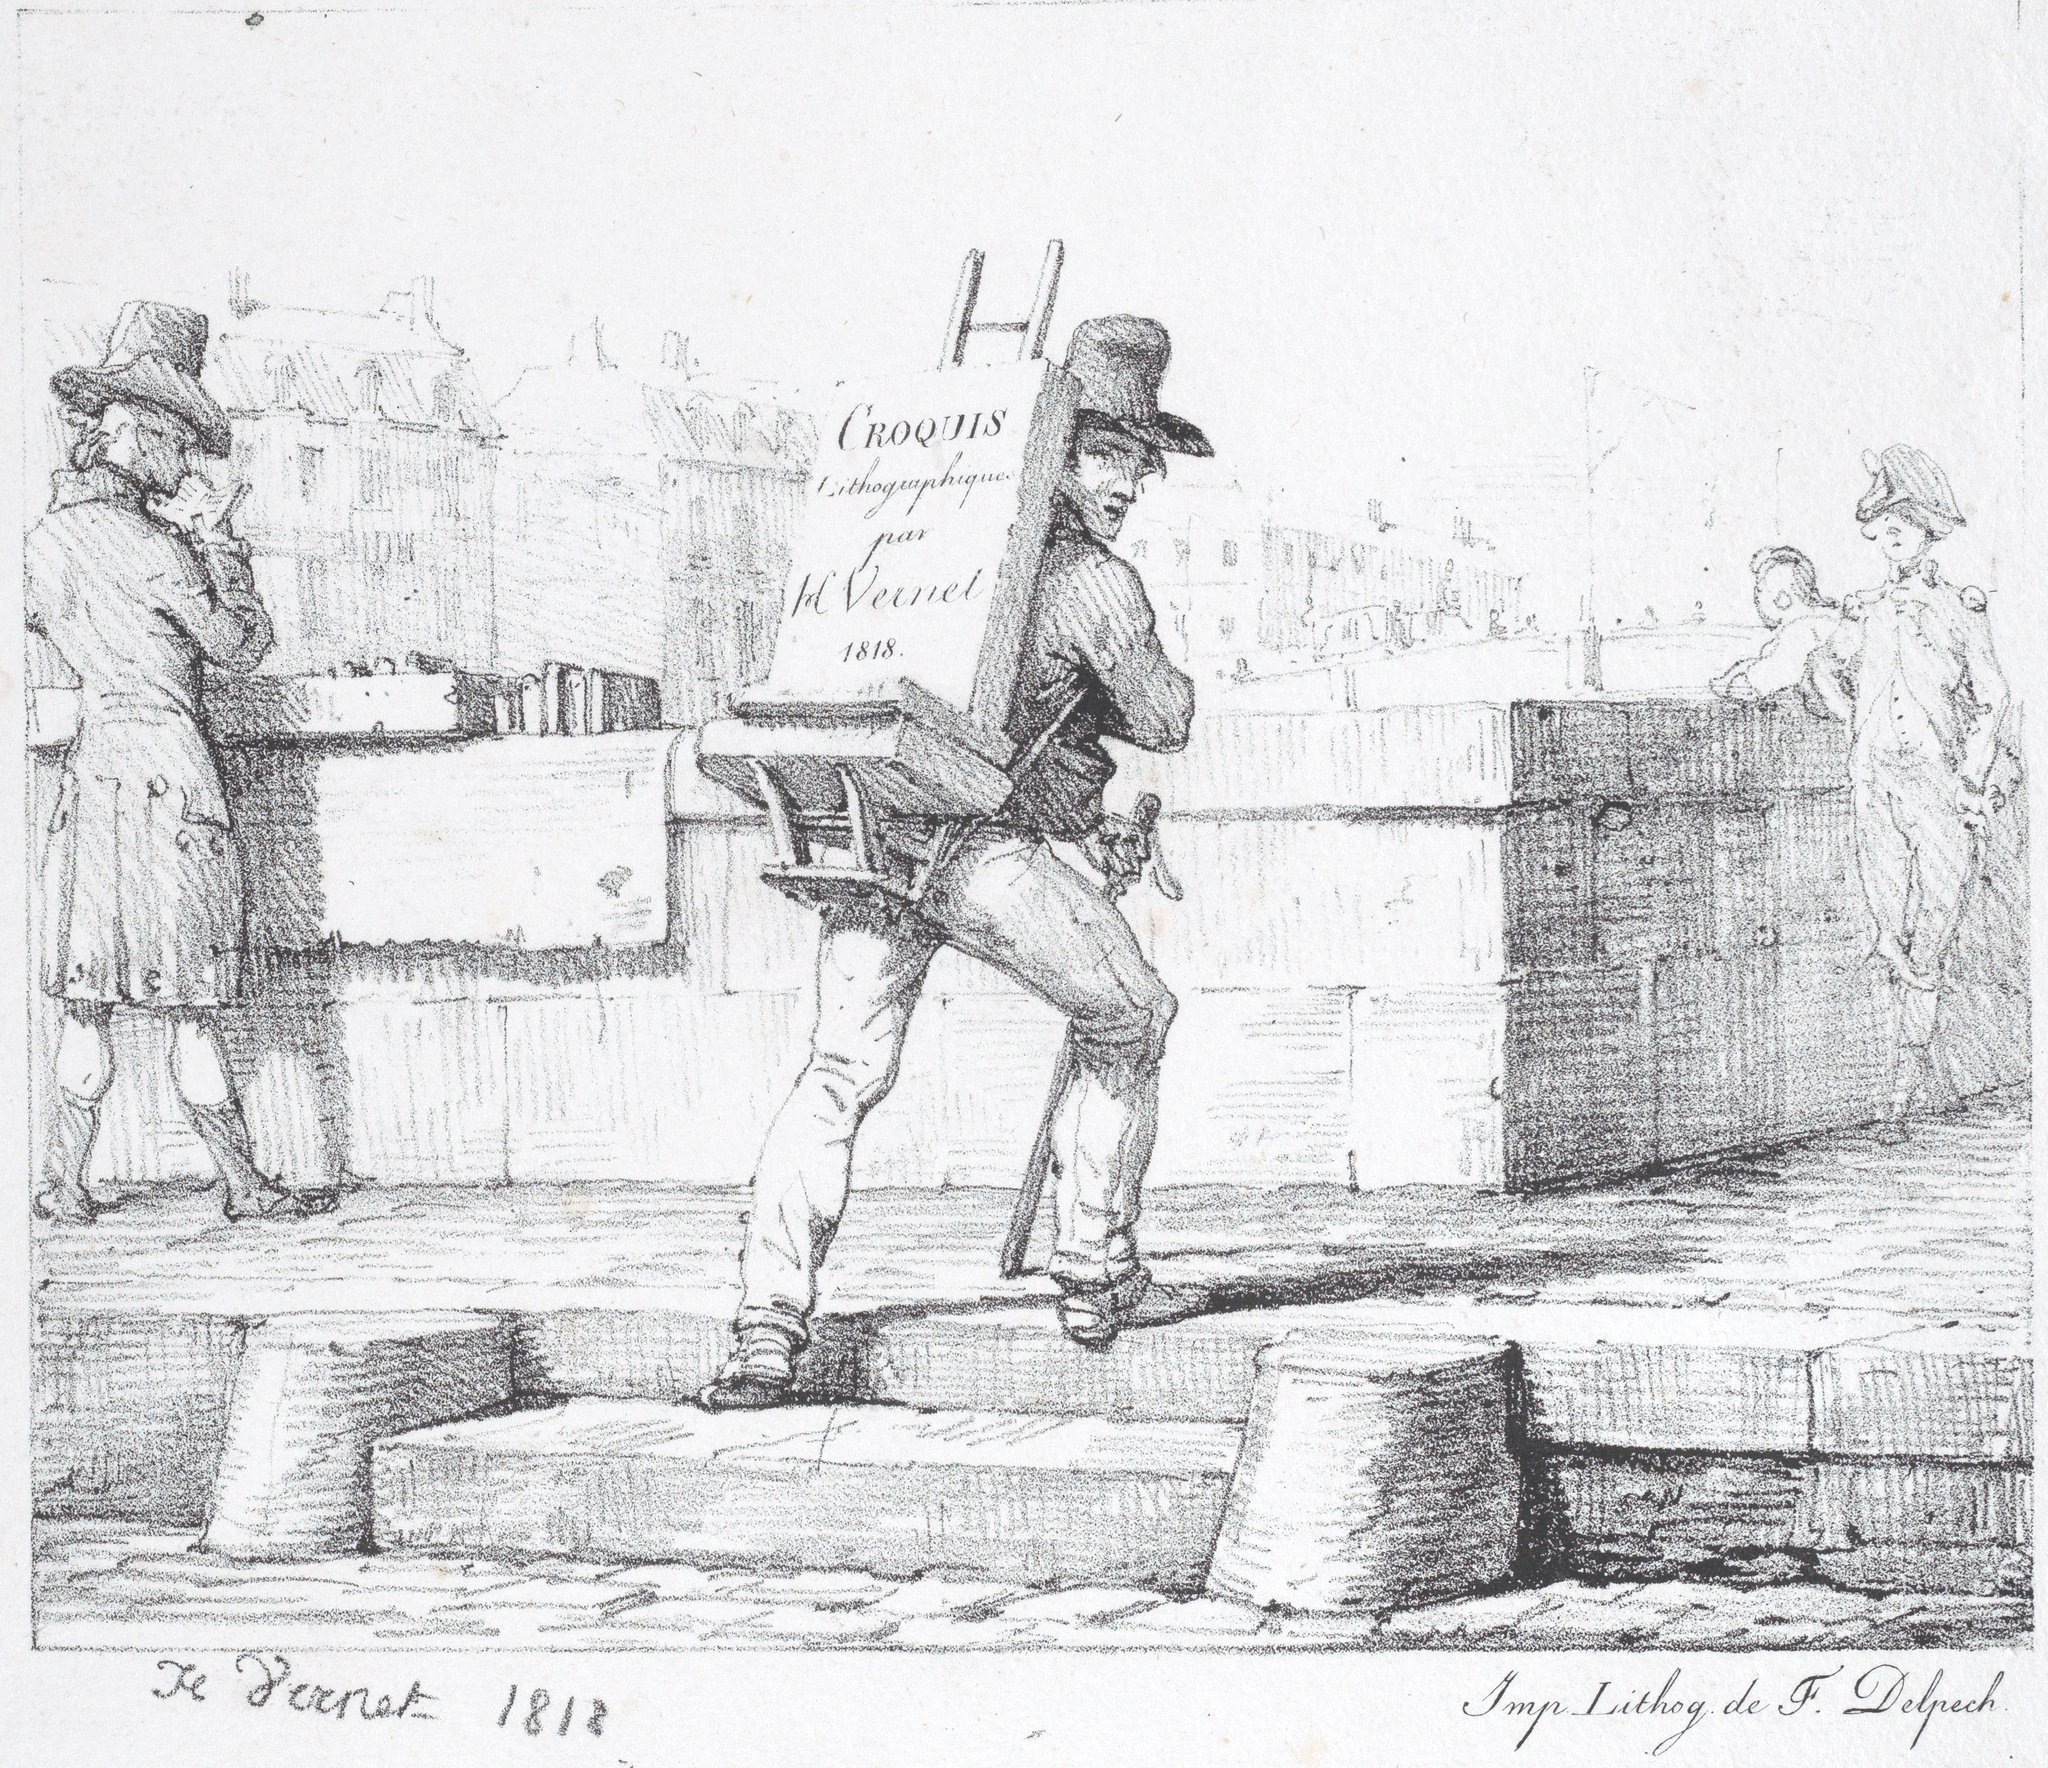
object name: print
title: The Carrier of Lithographic Stones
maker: horace vernet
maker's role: artist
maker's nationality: french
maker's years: 1789-1863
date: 1818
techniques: lithograph